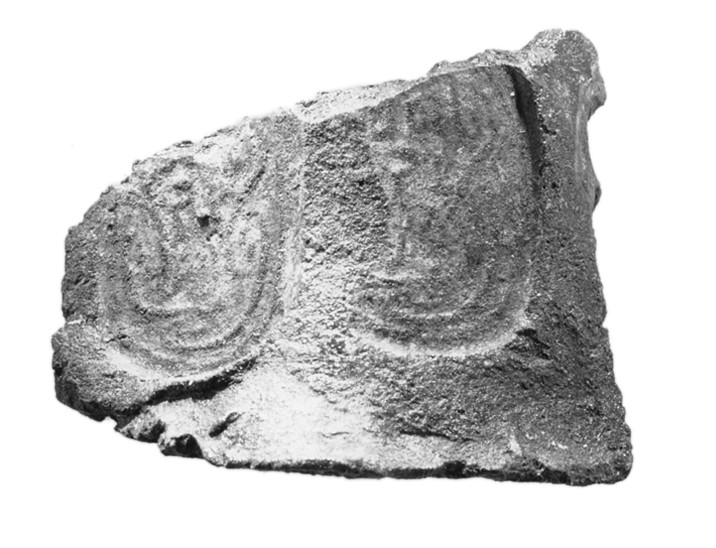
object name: sealing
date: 1981-1640 BCE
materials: mud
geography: egypt